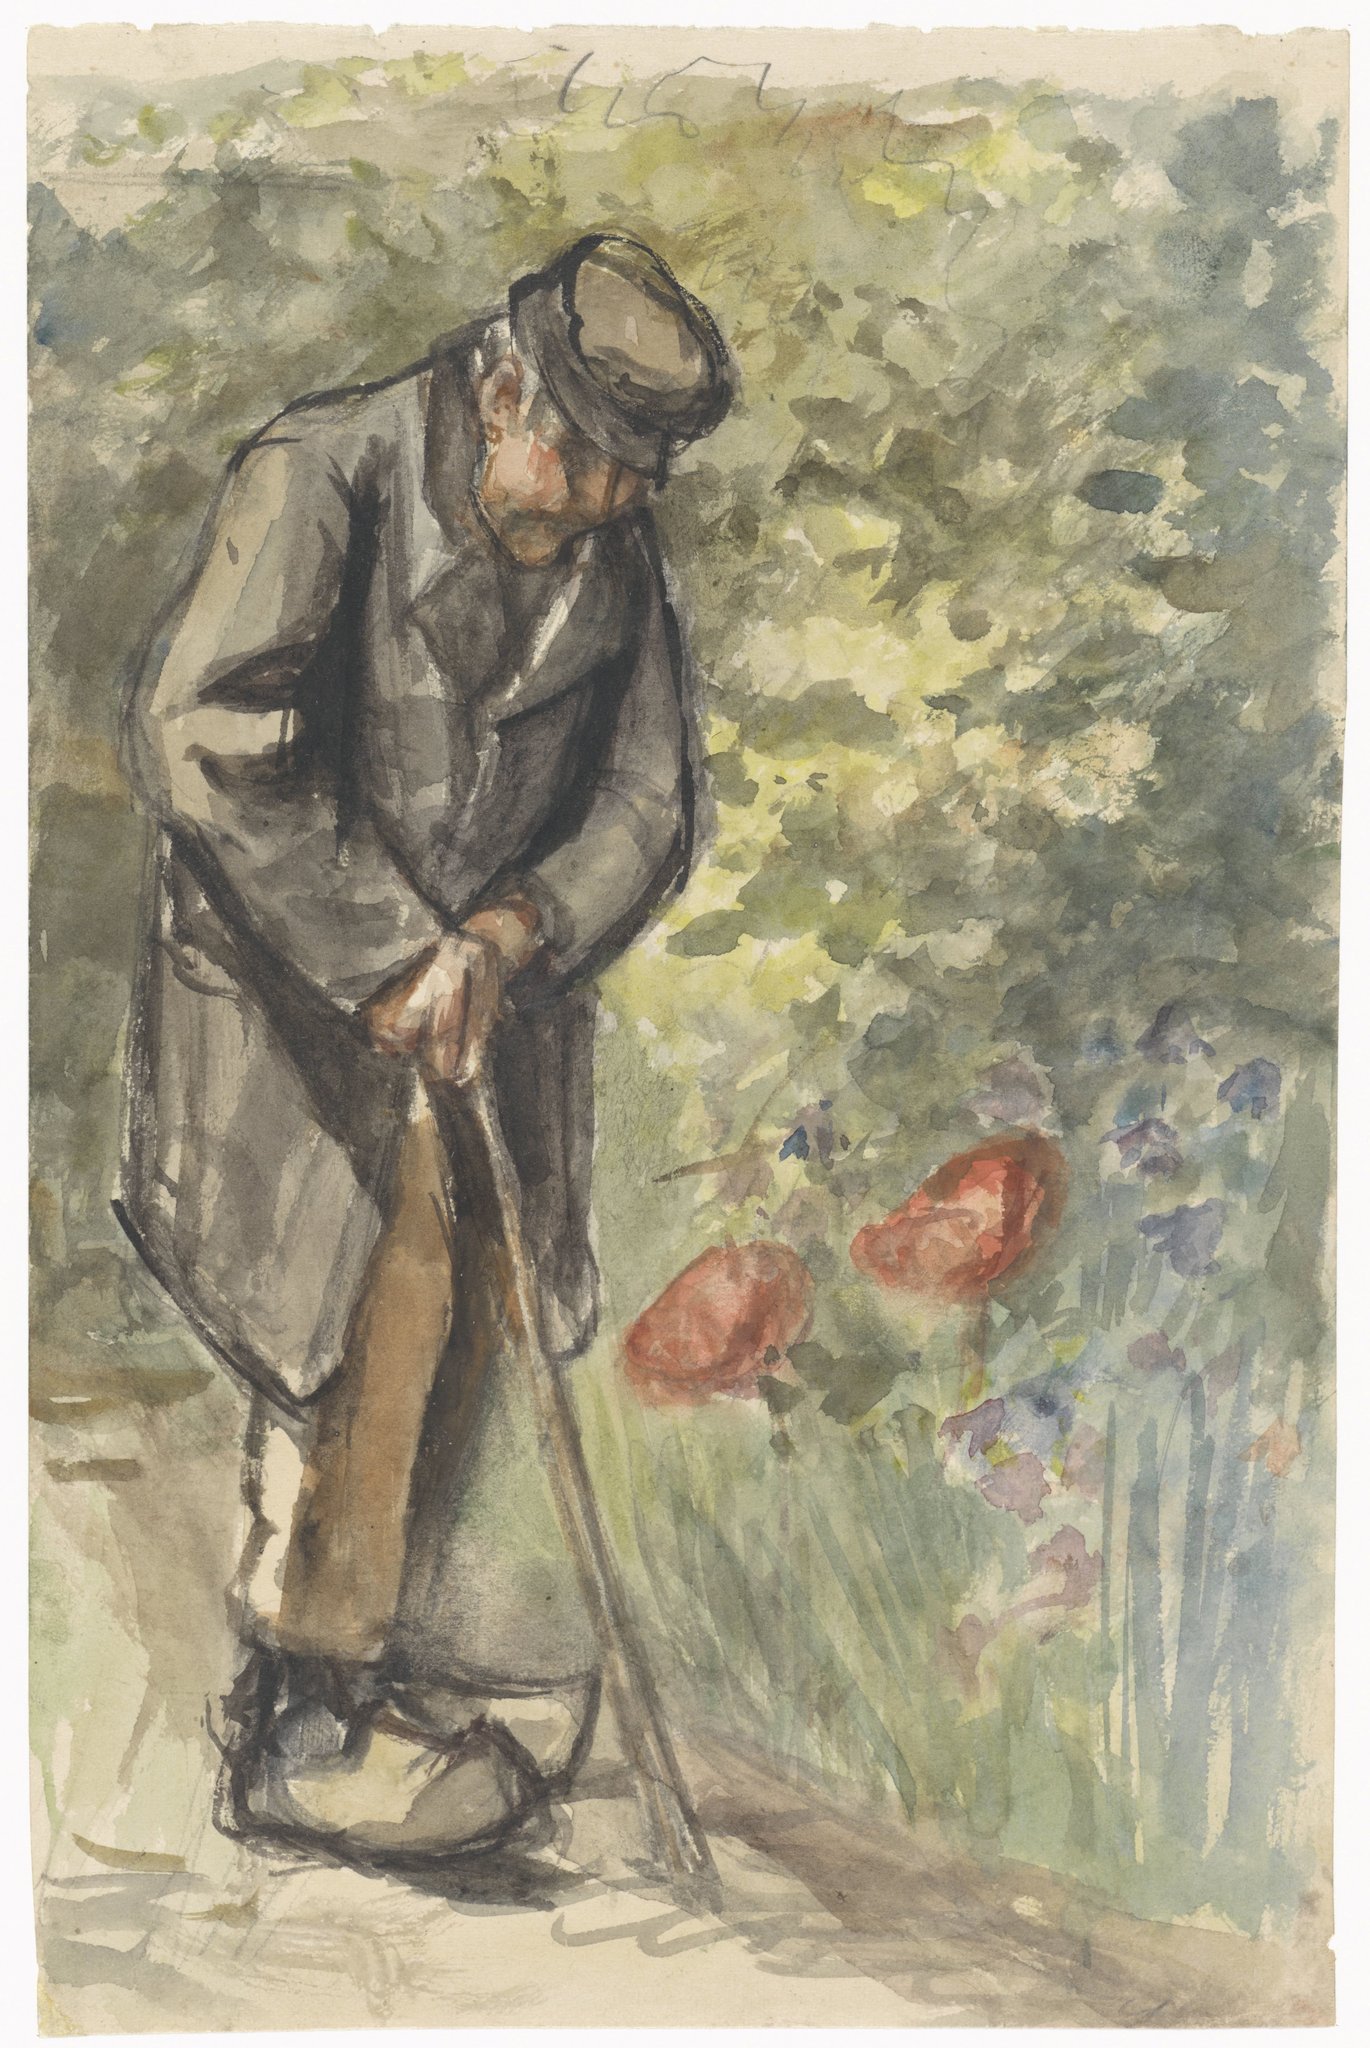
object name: watercolor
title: Oude man leunend op zijn stok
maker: jozef israëls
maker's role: draughtsman, painter, print maker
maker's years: 1824-1911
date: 1834-1911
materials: paper, pencil, watercolor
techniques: brush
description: Oude man leunend op zijn stok, bij bloemen langs een pad.